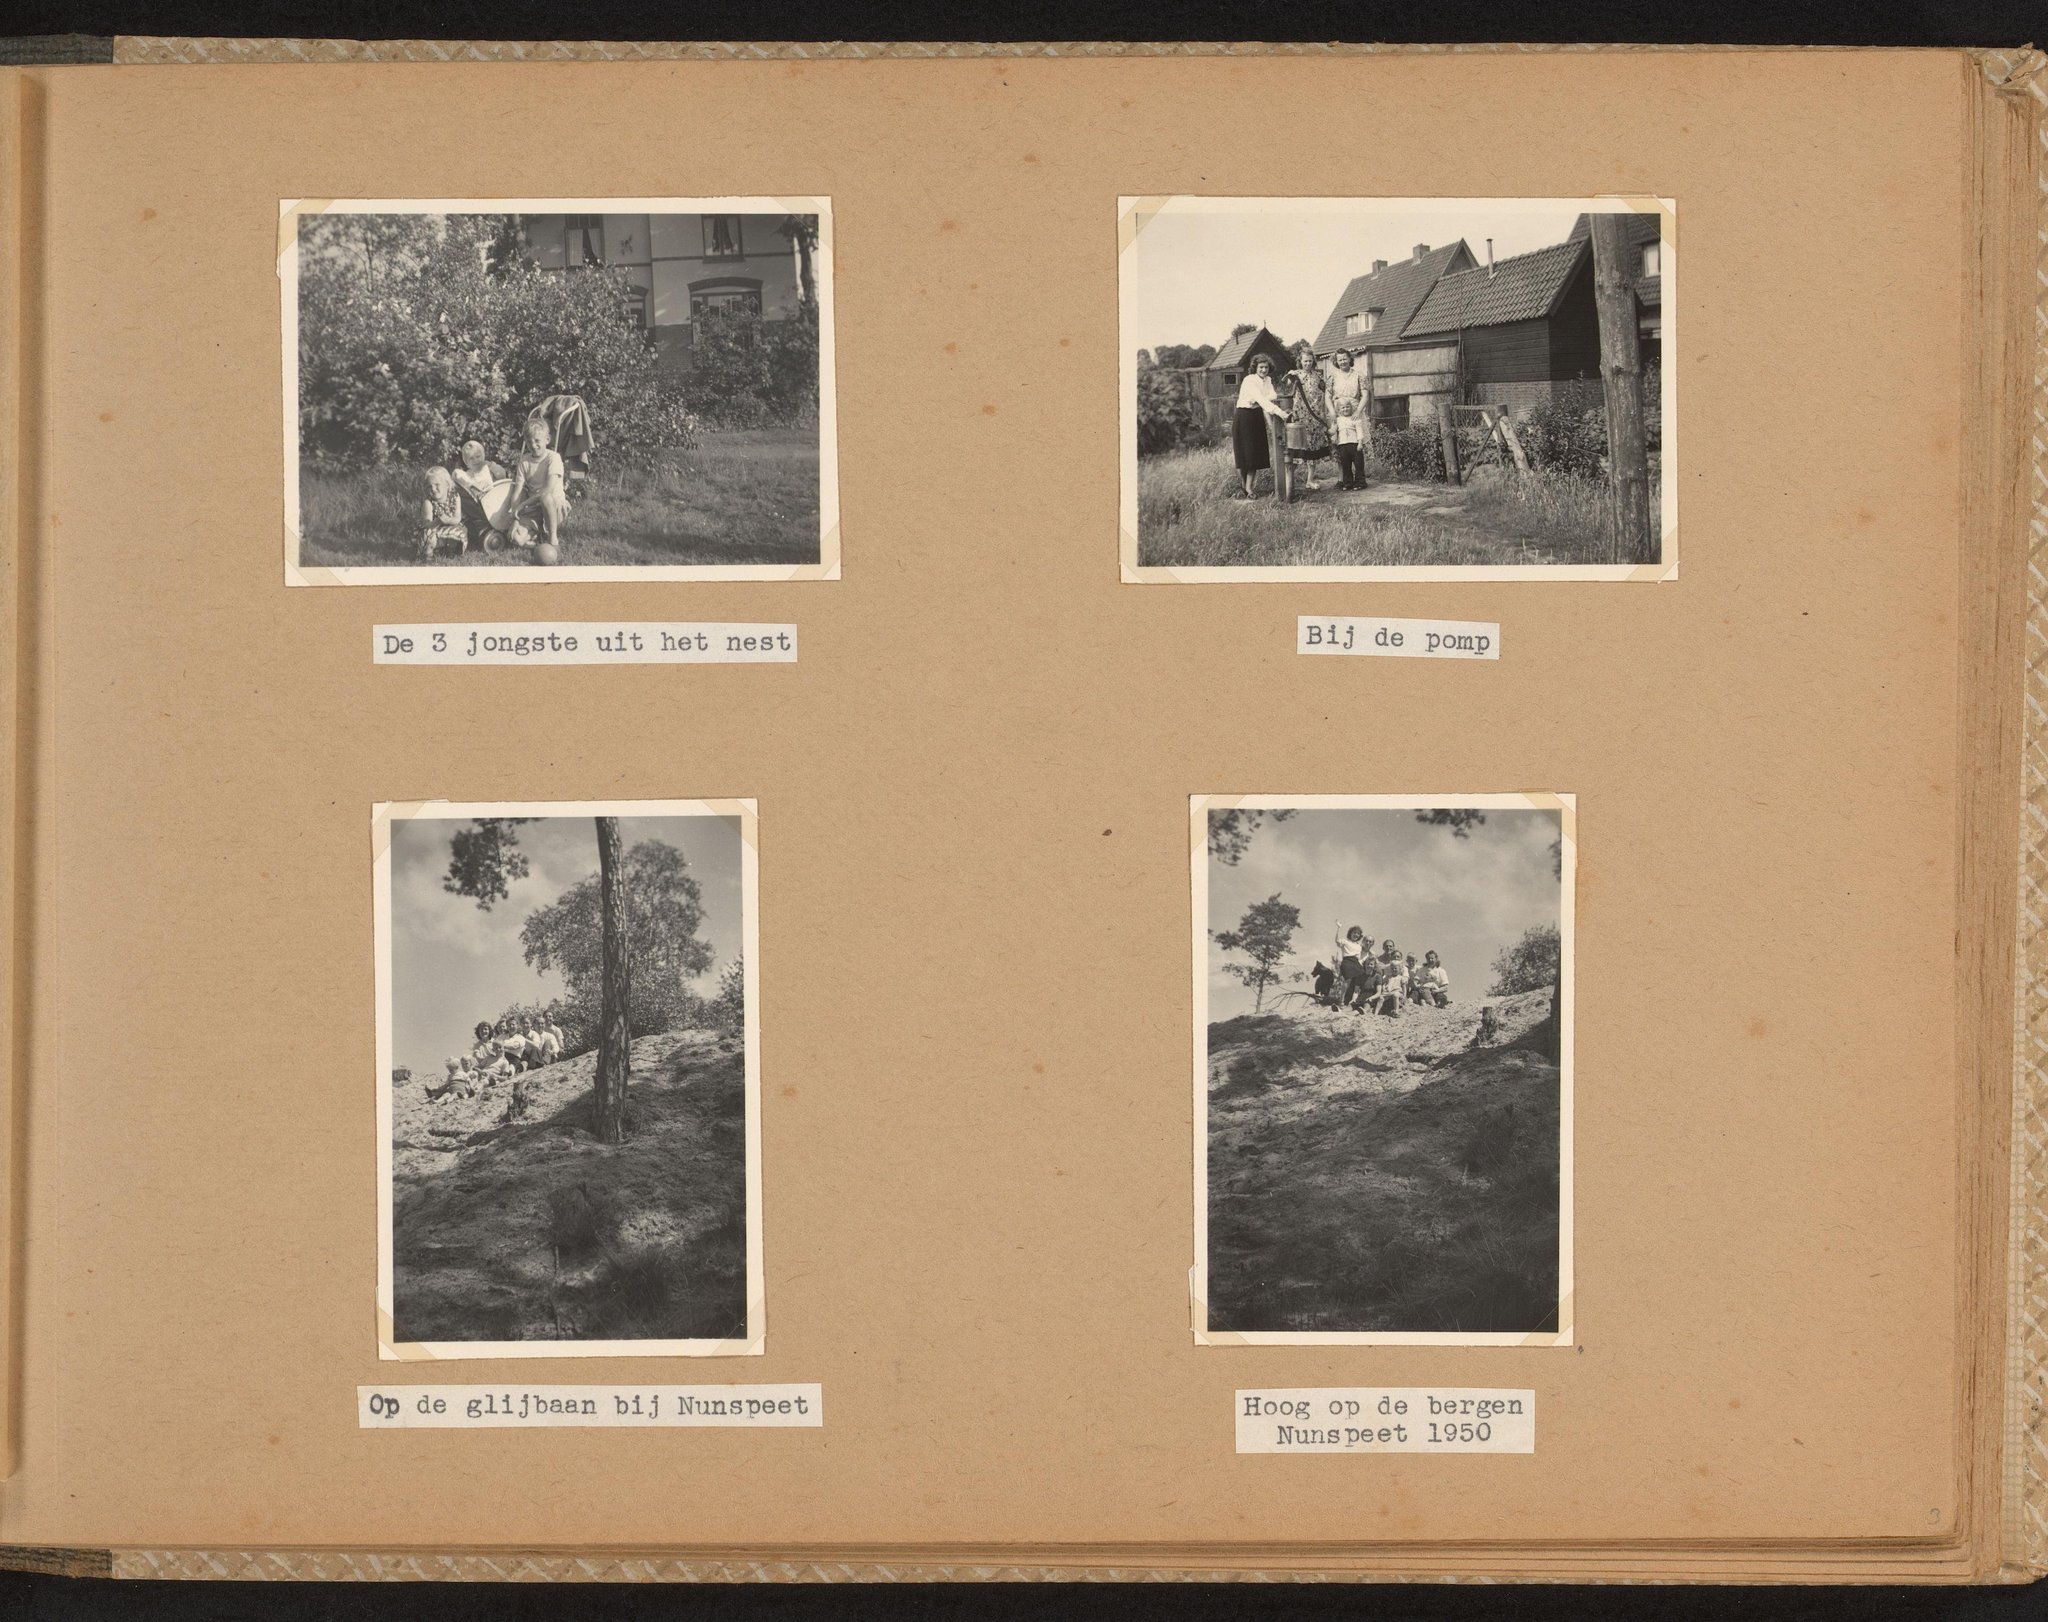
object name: photograph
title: Nunspeet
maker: Anonymous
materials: paper, photographic support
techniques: gelatin silver print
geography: netherlands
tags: the family travelling, on holiday, outing, pleasure trip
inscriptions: inscription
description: Albumblad met vier foto's van een vakantie met het gezin in Nunspeet, zomer 1950. Onder de foto's uitgeknipte papiertjes met getypte opschriften. Onderdeel van het tweede fotoalbum met foto's van familievakanties in Nederland, België, Luxemburg en Frankrijk in 1950-1951.